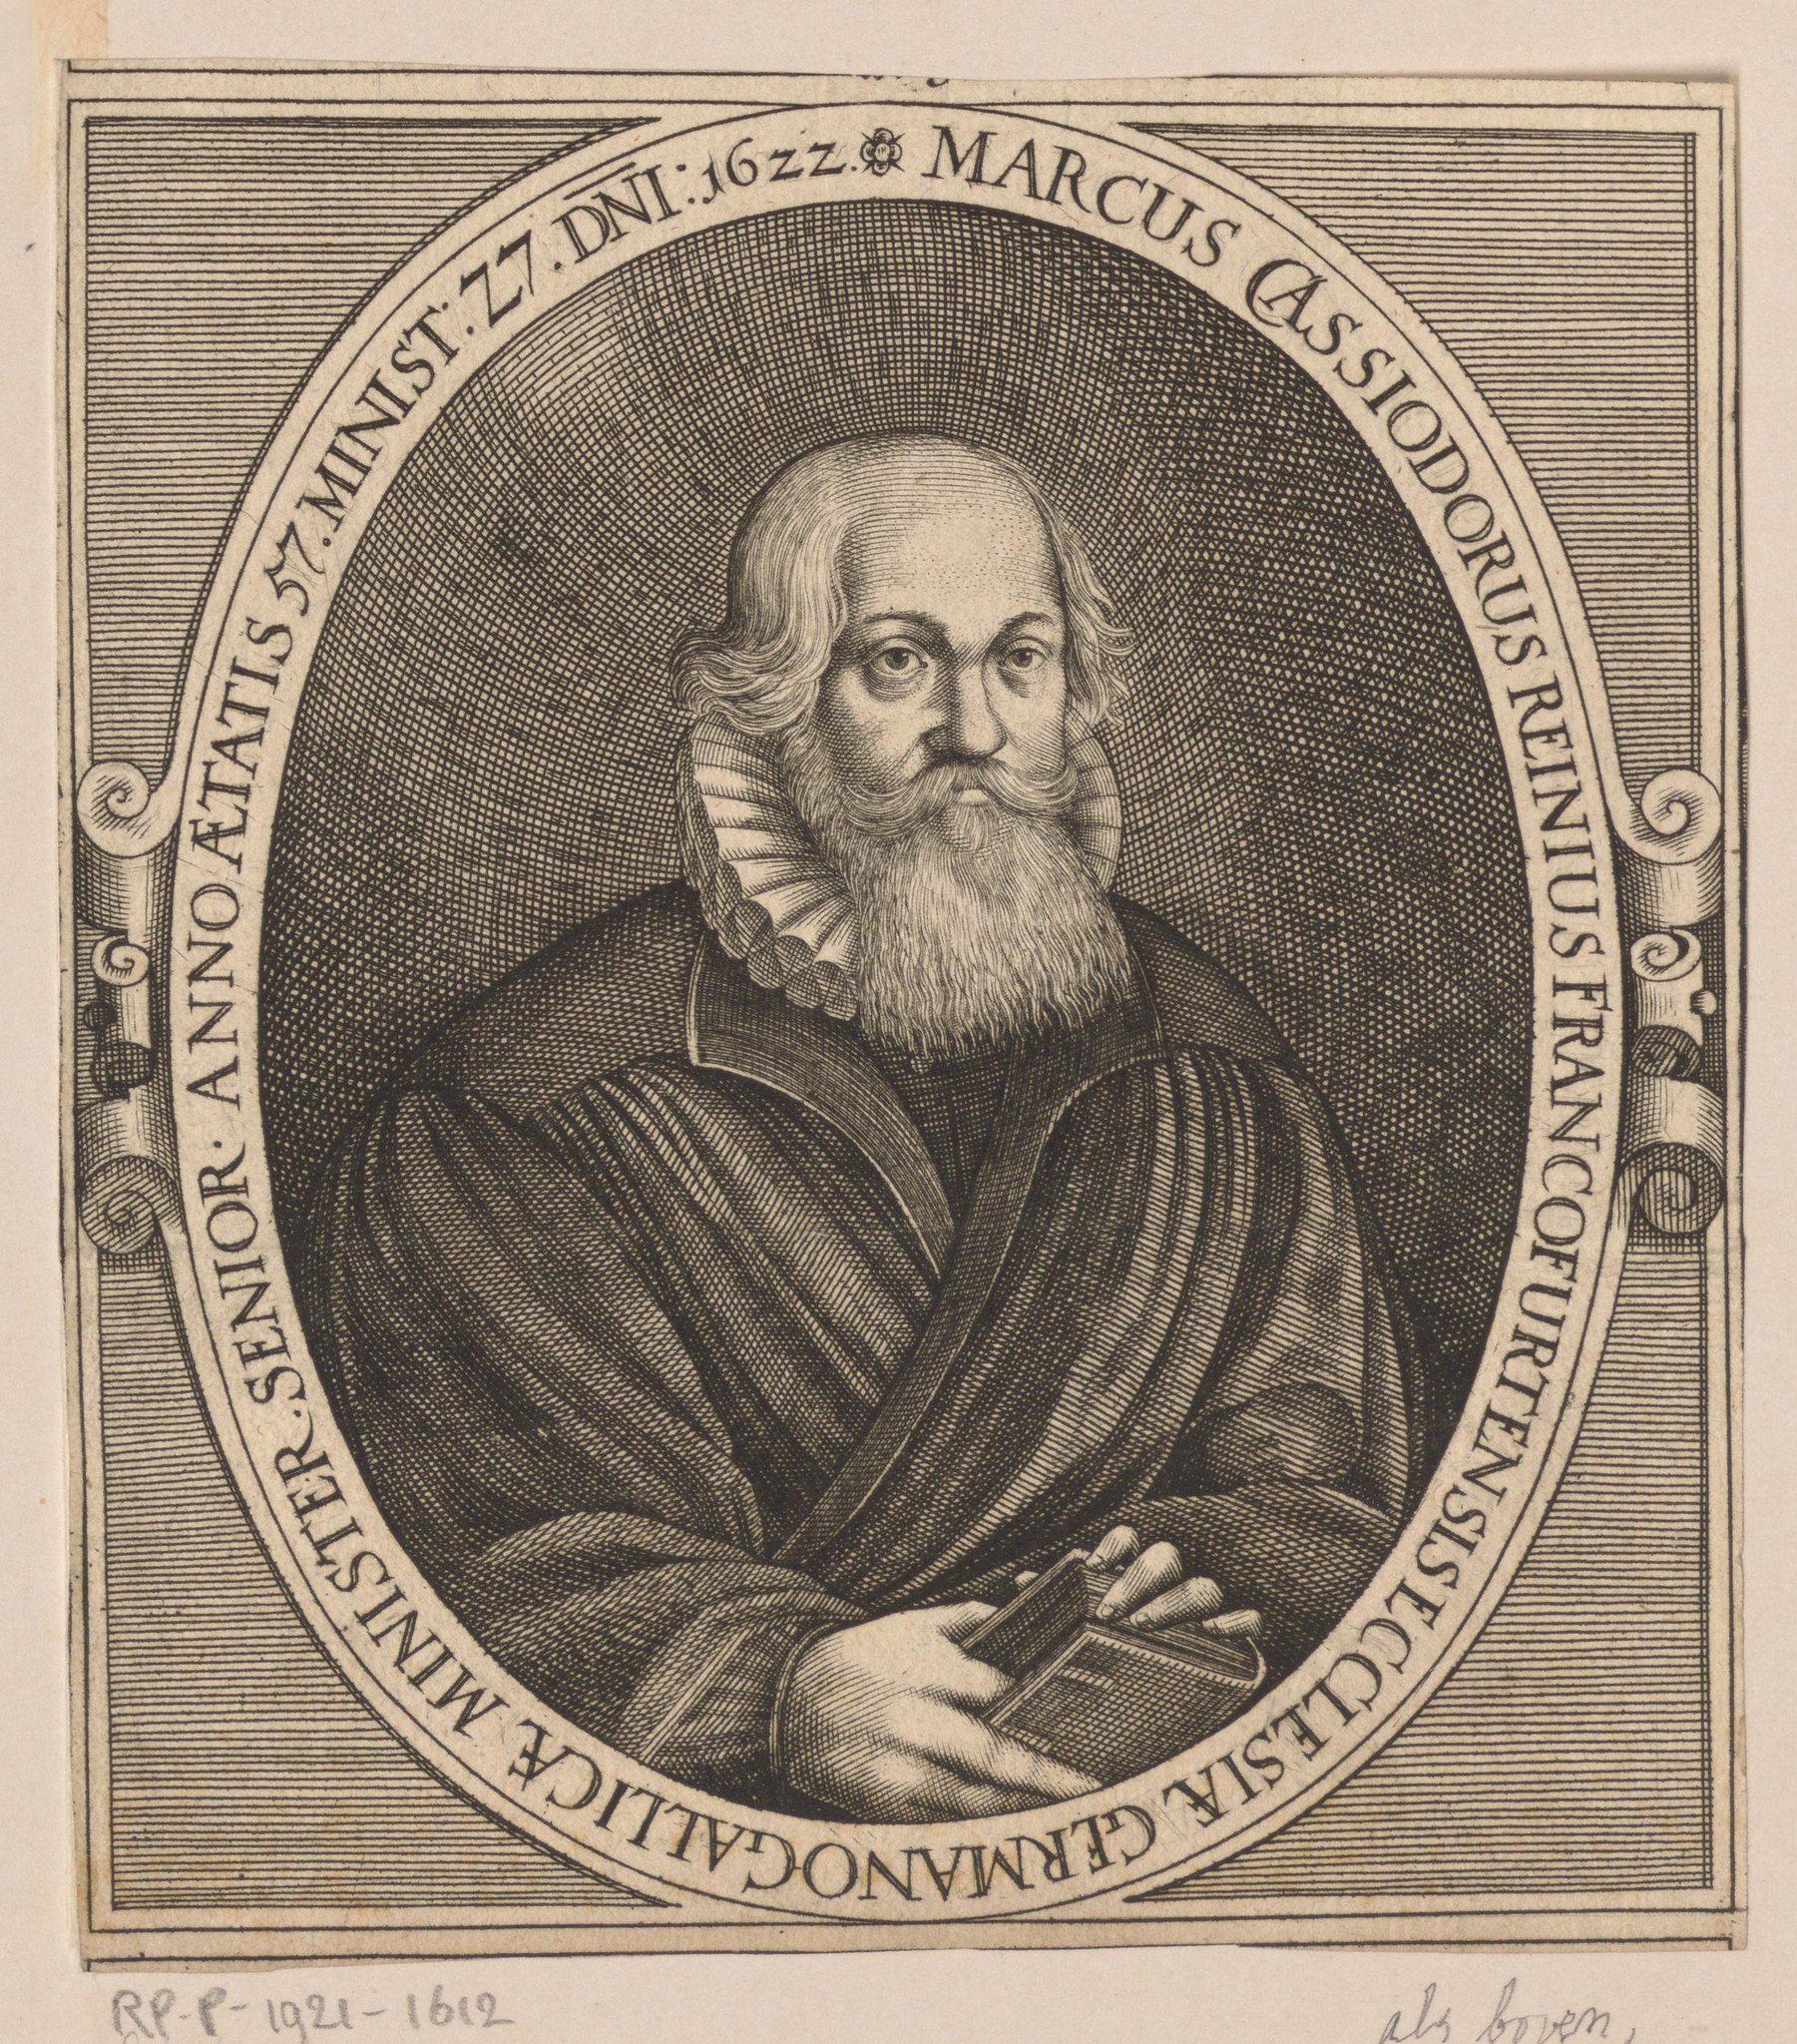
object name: print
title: Portret van Marcus Cassiodorus Reinius op 57-jarige leeftijd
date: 1622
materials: paper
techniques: engraving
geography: frankfurt am main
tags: historical persons, book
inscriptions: collector's mark: Lugt 2233